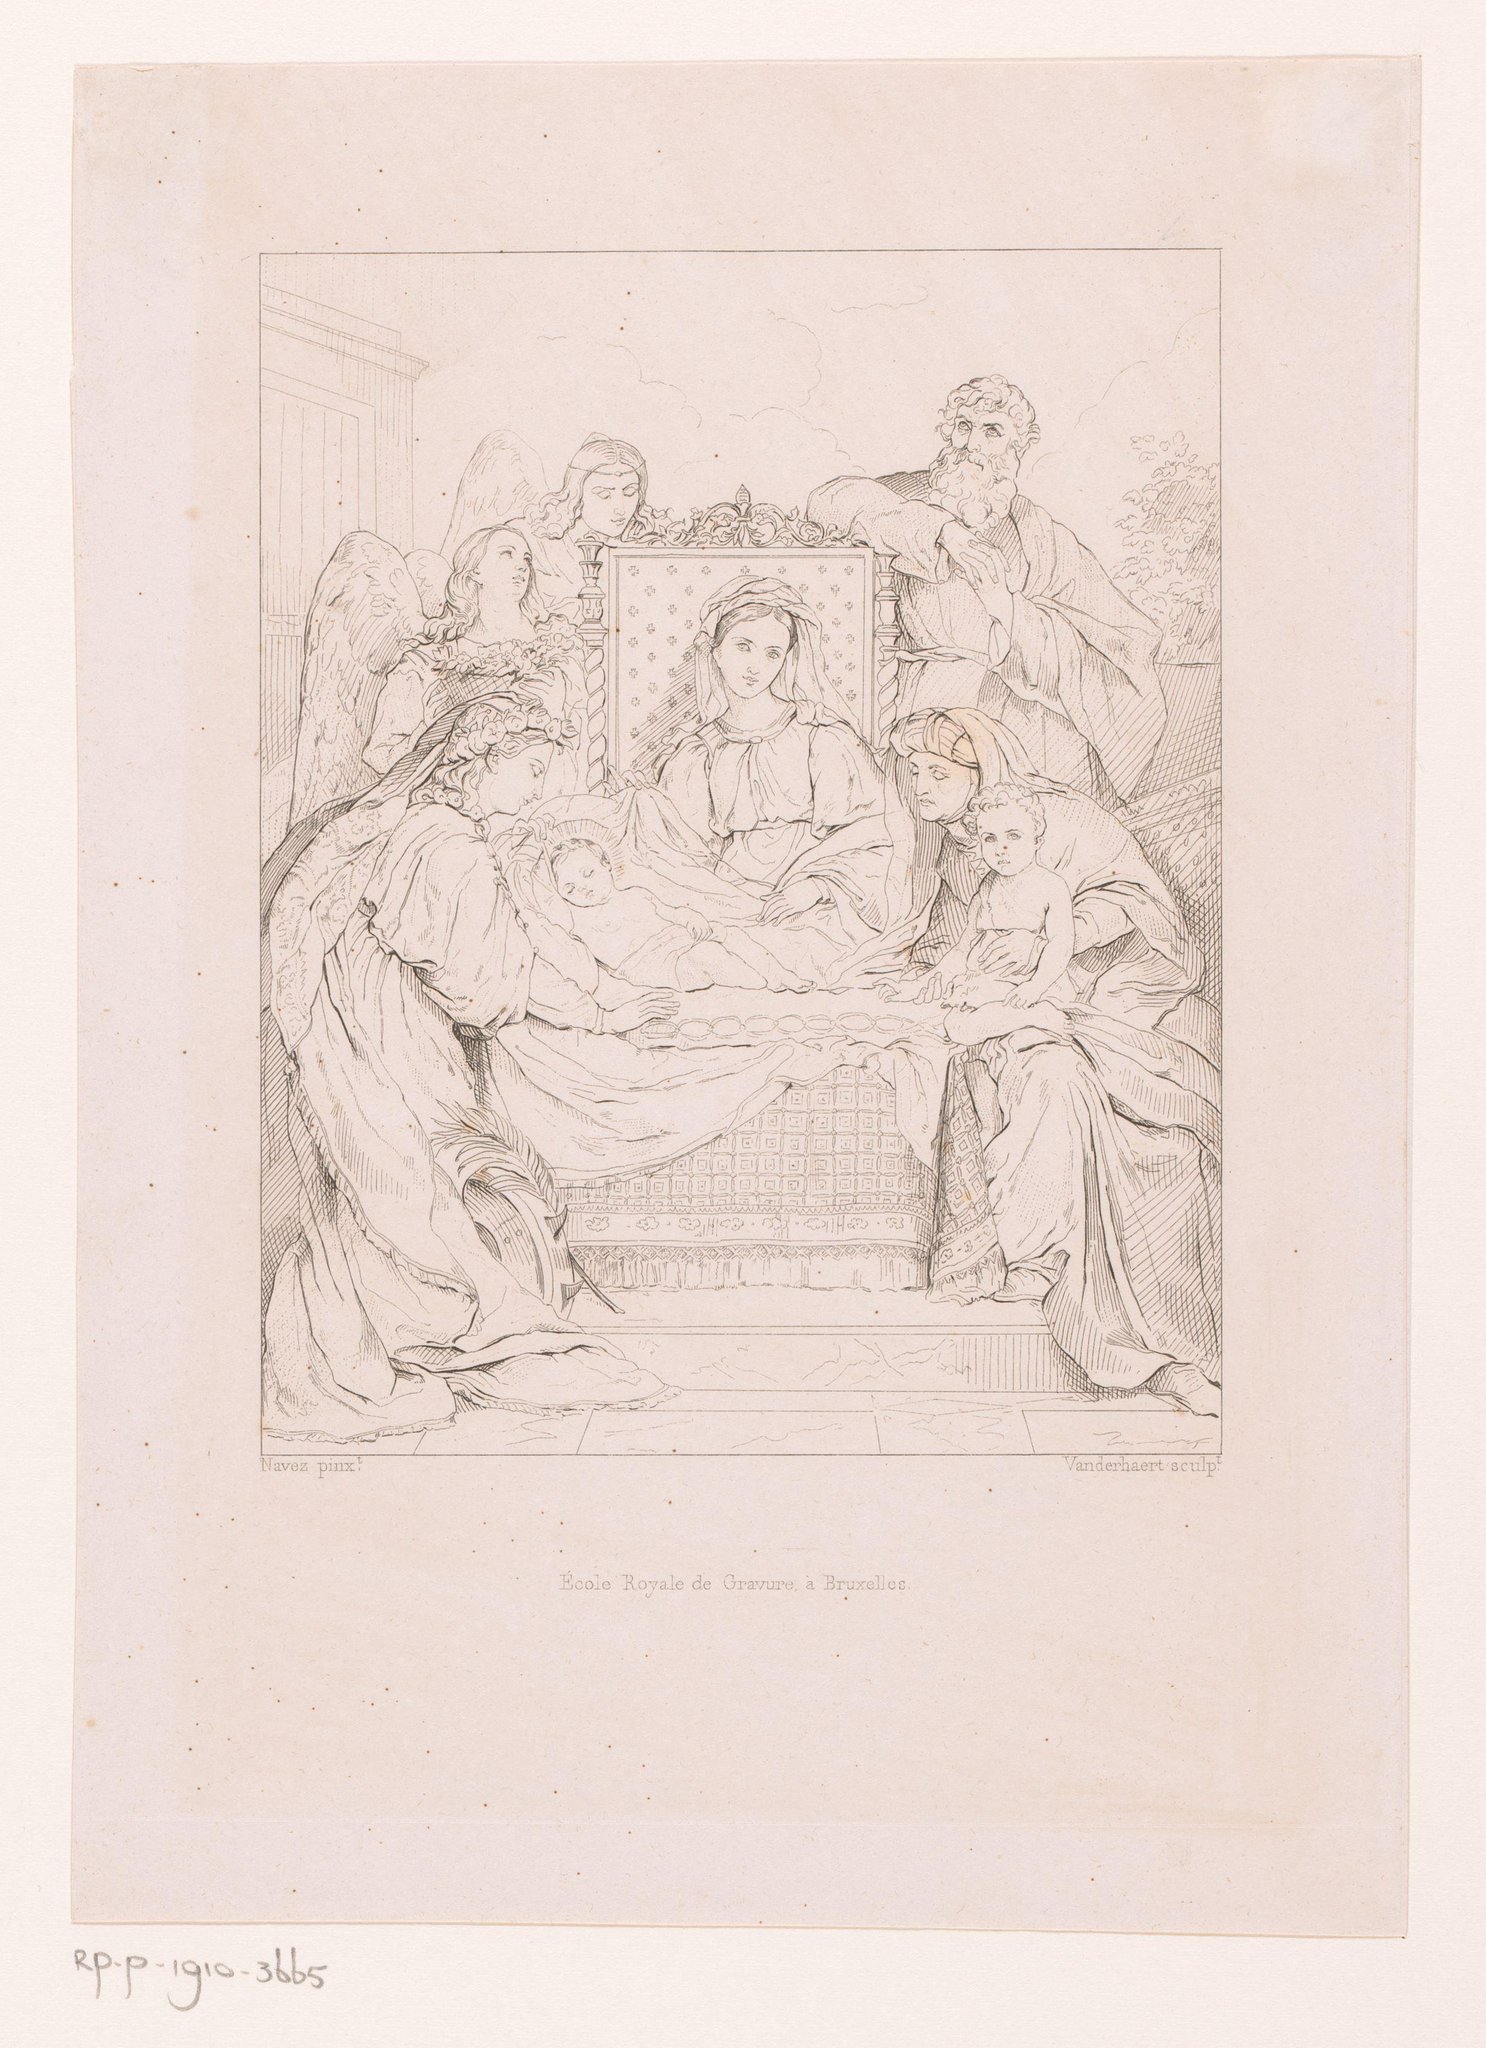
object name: print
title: Christus ligt te slapen op de schoot van Maria, omringd door twee engelen, Jozef, Catharina, Elisabet en Johannes de Doper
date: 1836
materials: paper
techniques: etching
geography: brussels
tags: the virgin martyr catherine of alexandria; possible attributes: book, crown, emperor maxentius, palm-branch, ring, sword, wheel, john the baptist; possible attributes: book, reed cross, baptismal cup, honeycomb, lamb, staff, the foster-father of christ, joseph of nazareth, husband of mary; possible attributes: flowering rod or wand, lily, carpenter's tools, mary sitting or enthroned, the christ-child in front of her, lying in her lap (or in front of her bosom), sometimes in pietà-posture, elisabeth, mother of john the baptist; possible attributes: john the baptist as child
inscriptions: collector's mark: Lugt 1485, collector's mark: Lugt 2228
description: Prent uit: Alvin, Louis. Compte-rendu du salon d'exposition de Bruxelles, 1836. Brussel: J.P. Meline, 1836, p. 284-285.